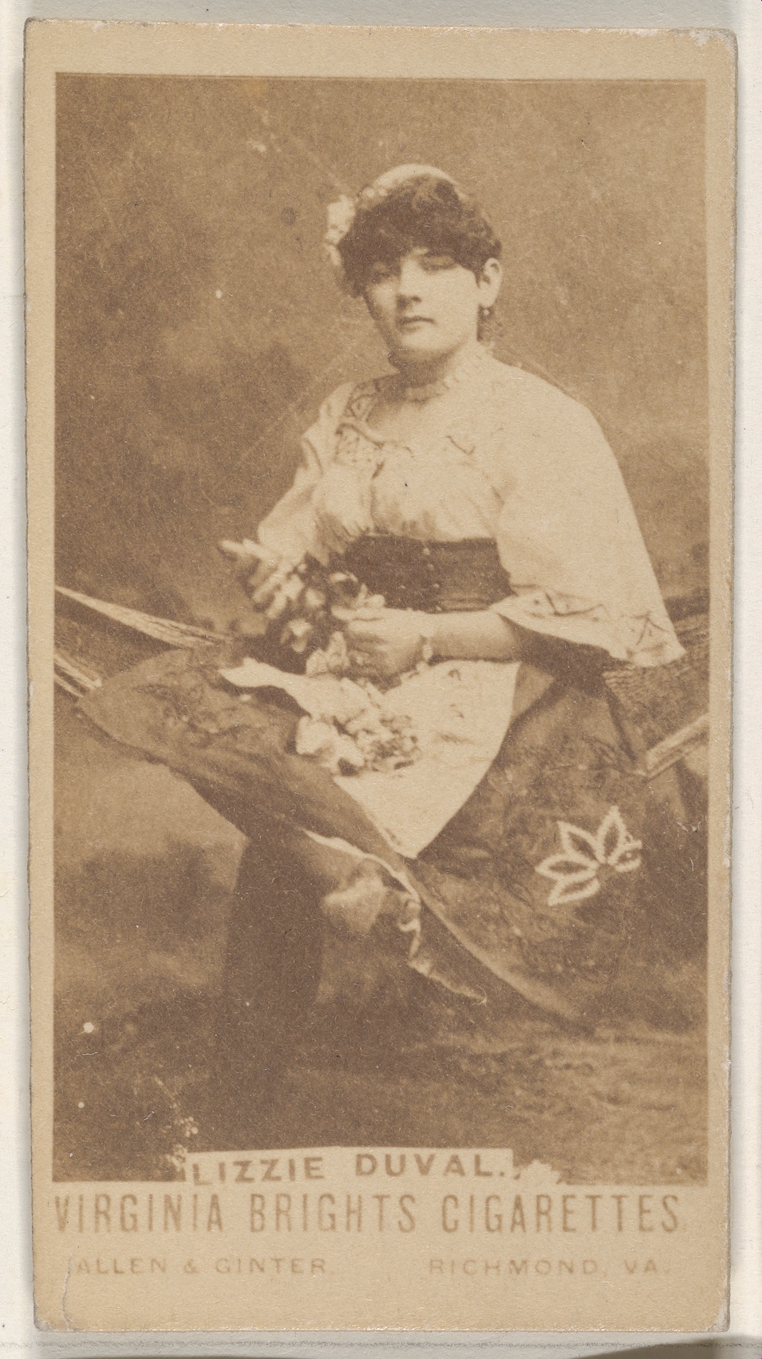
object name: photograph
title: Lizzie Duval, from the Actors and Actresses series (N45, Type 1) for Virginia Brights Cigarettes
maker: allen & ginter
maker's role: publisher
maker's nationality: american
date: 1888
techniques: albumen silver print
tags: portraits,women,actresses